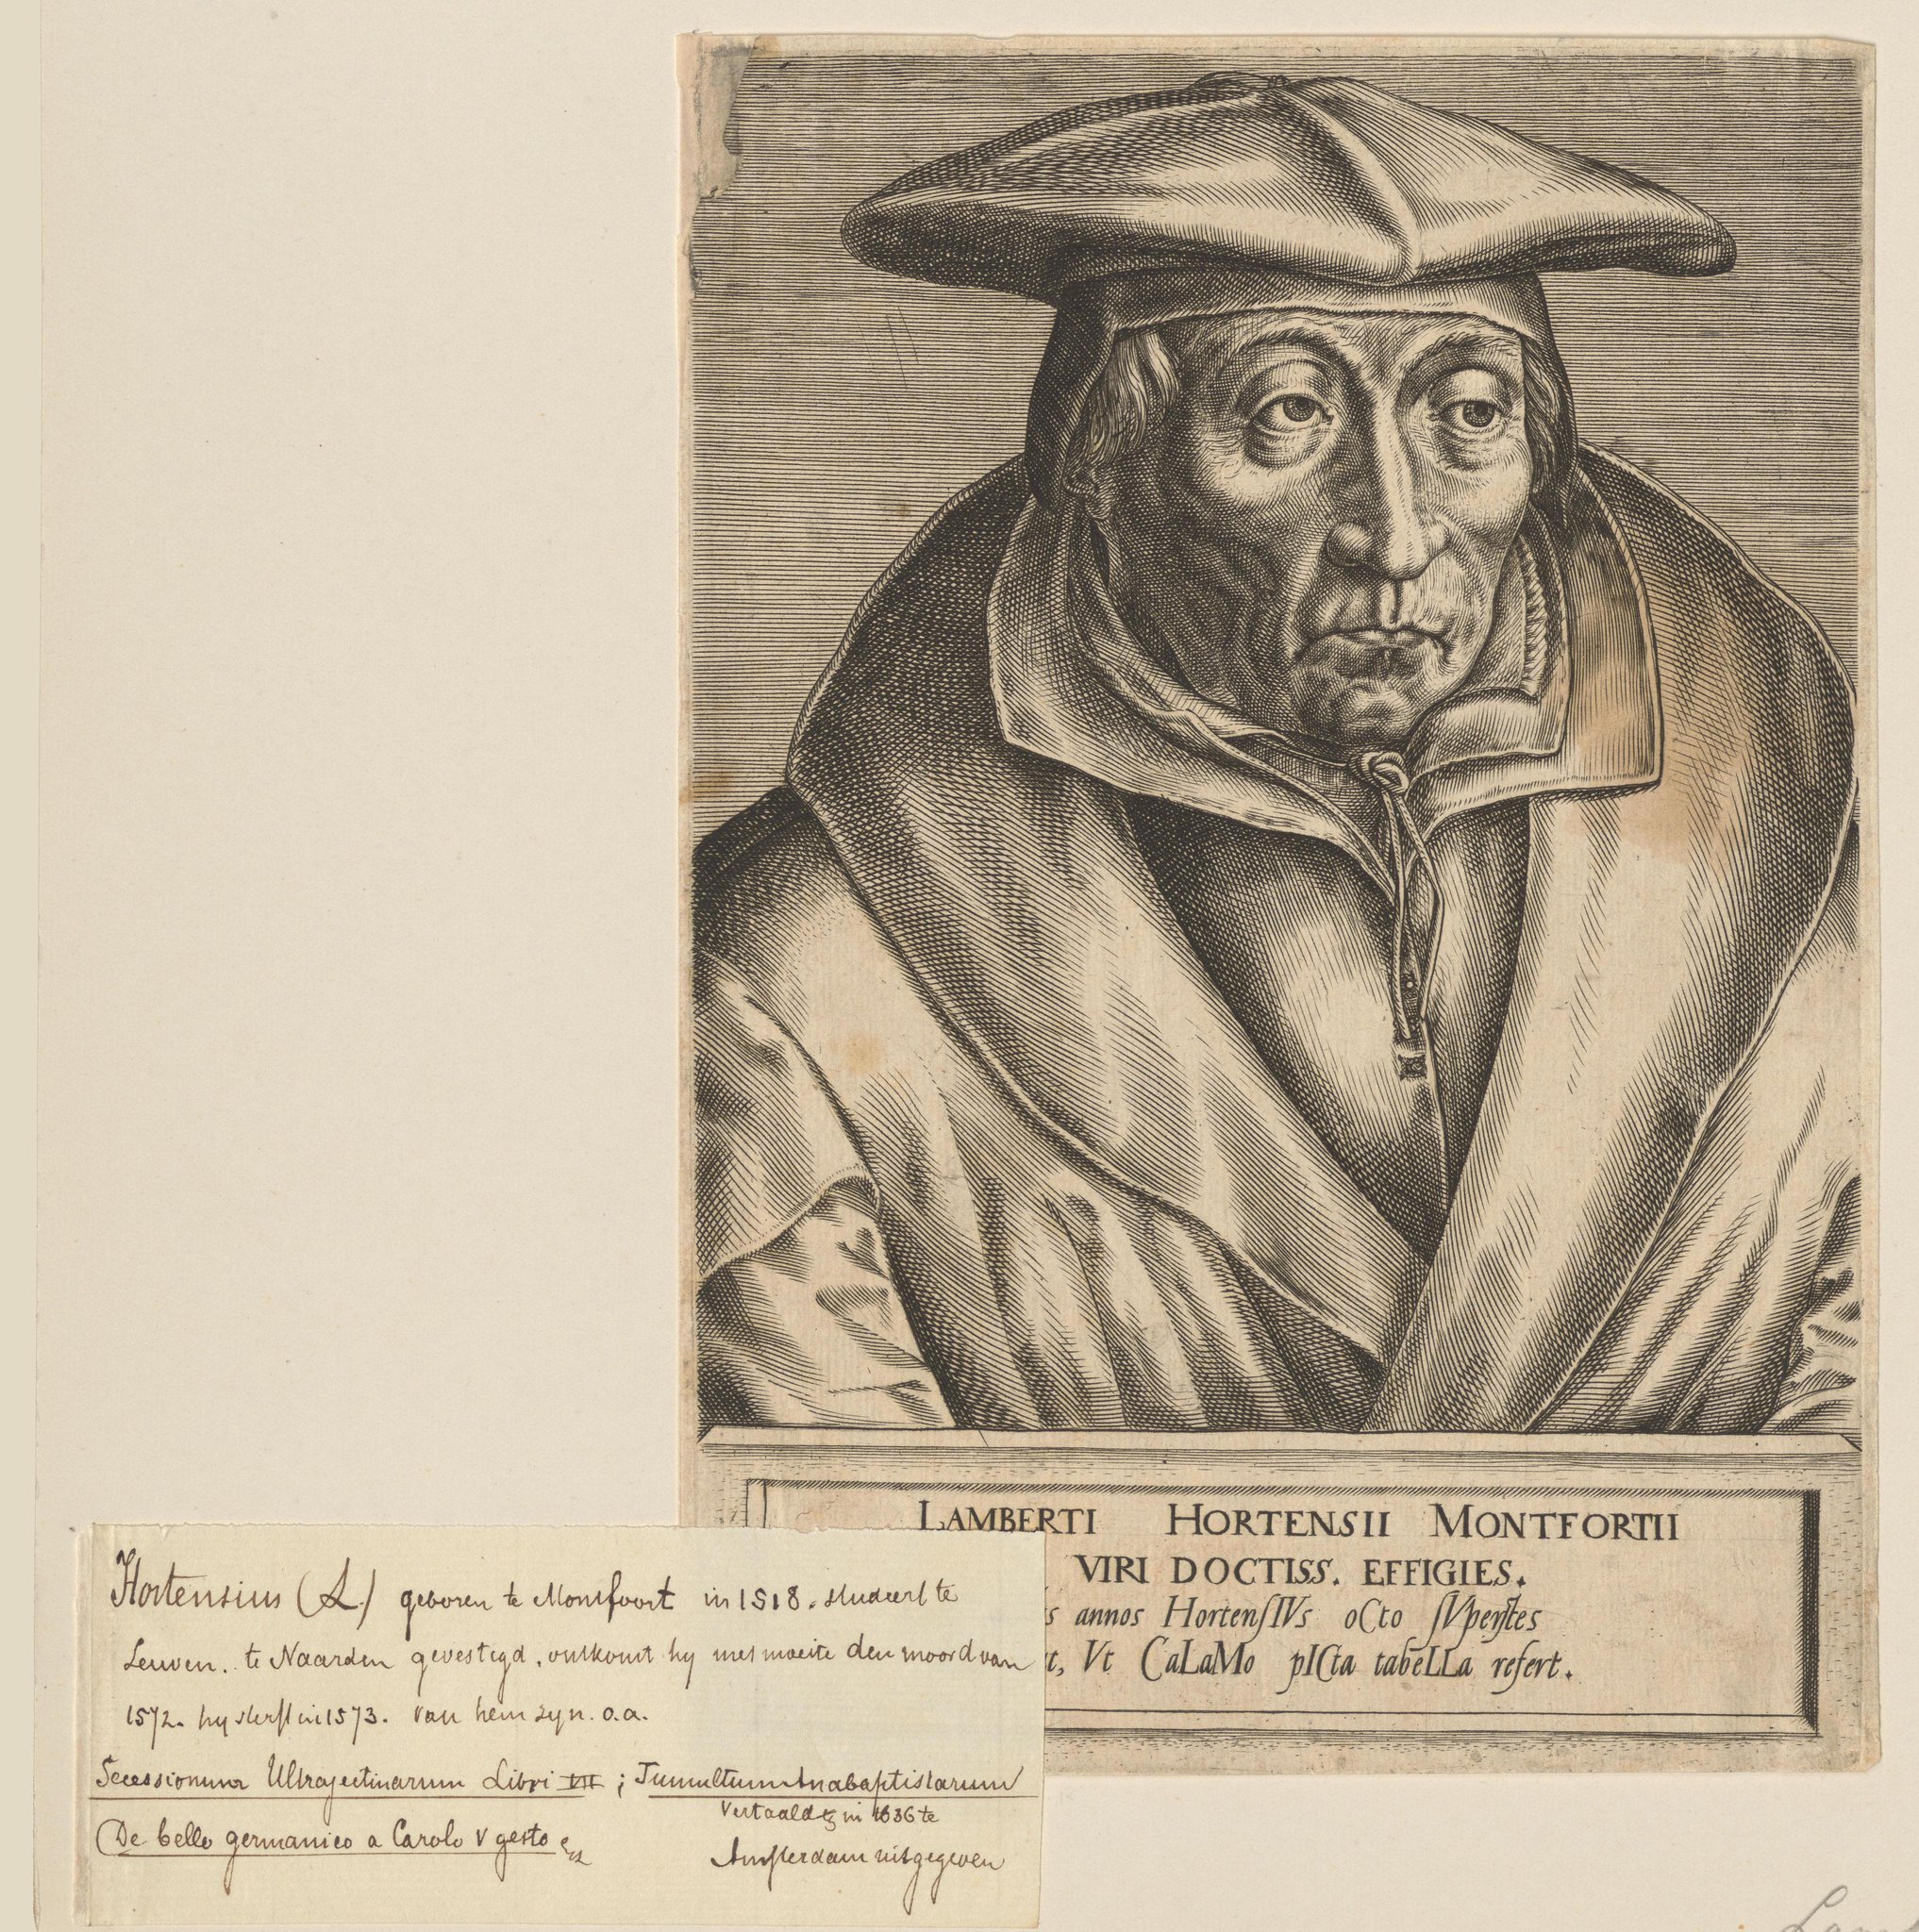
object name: book illustration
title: Portret van Lambertus Hortensius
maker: Anonymous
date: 1600-1699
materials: paper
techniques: engraving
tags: priest, historical persons, portrait of a writer